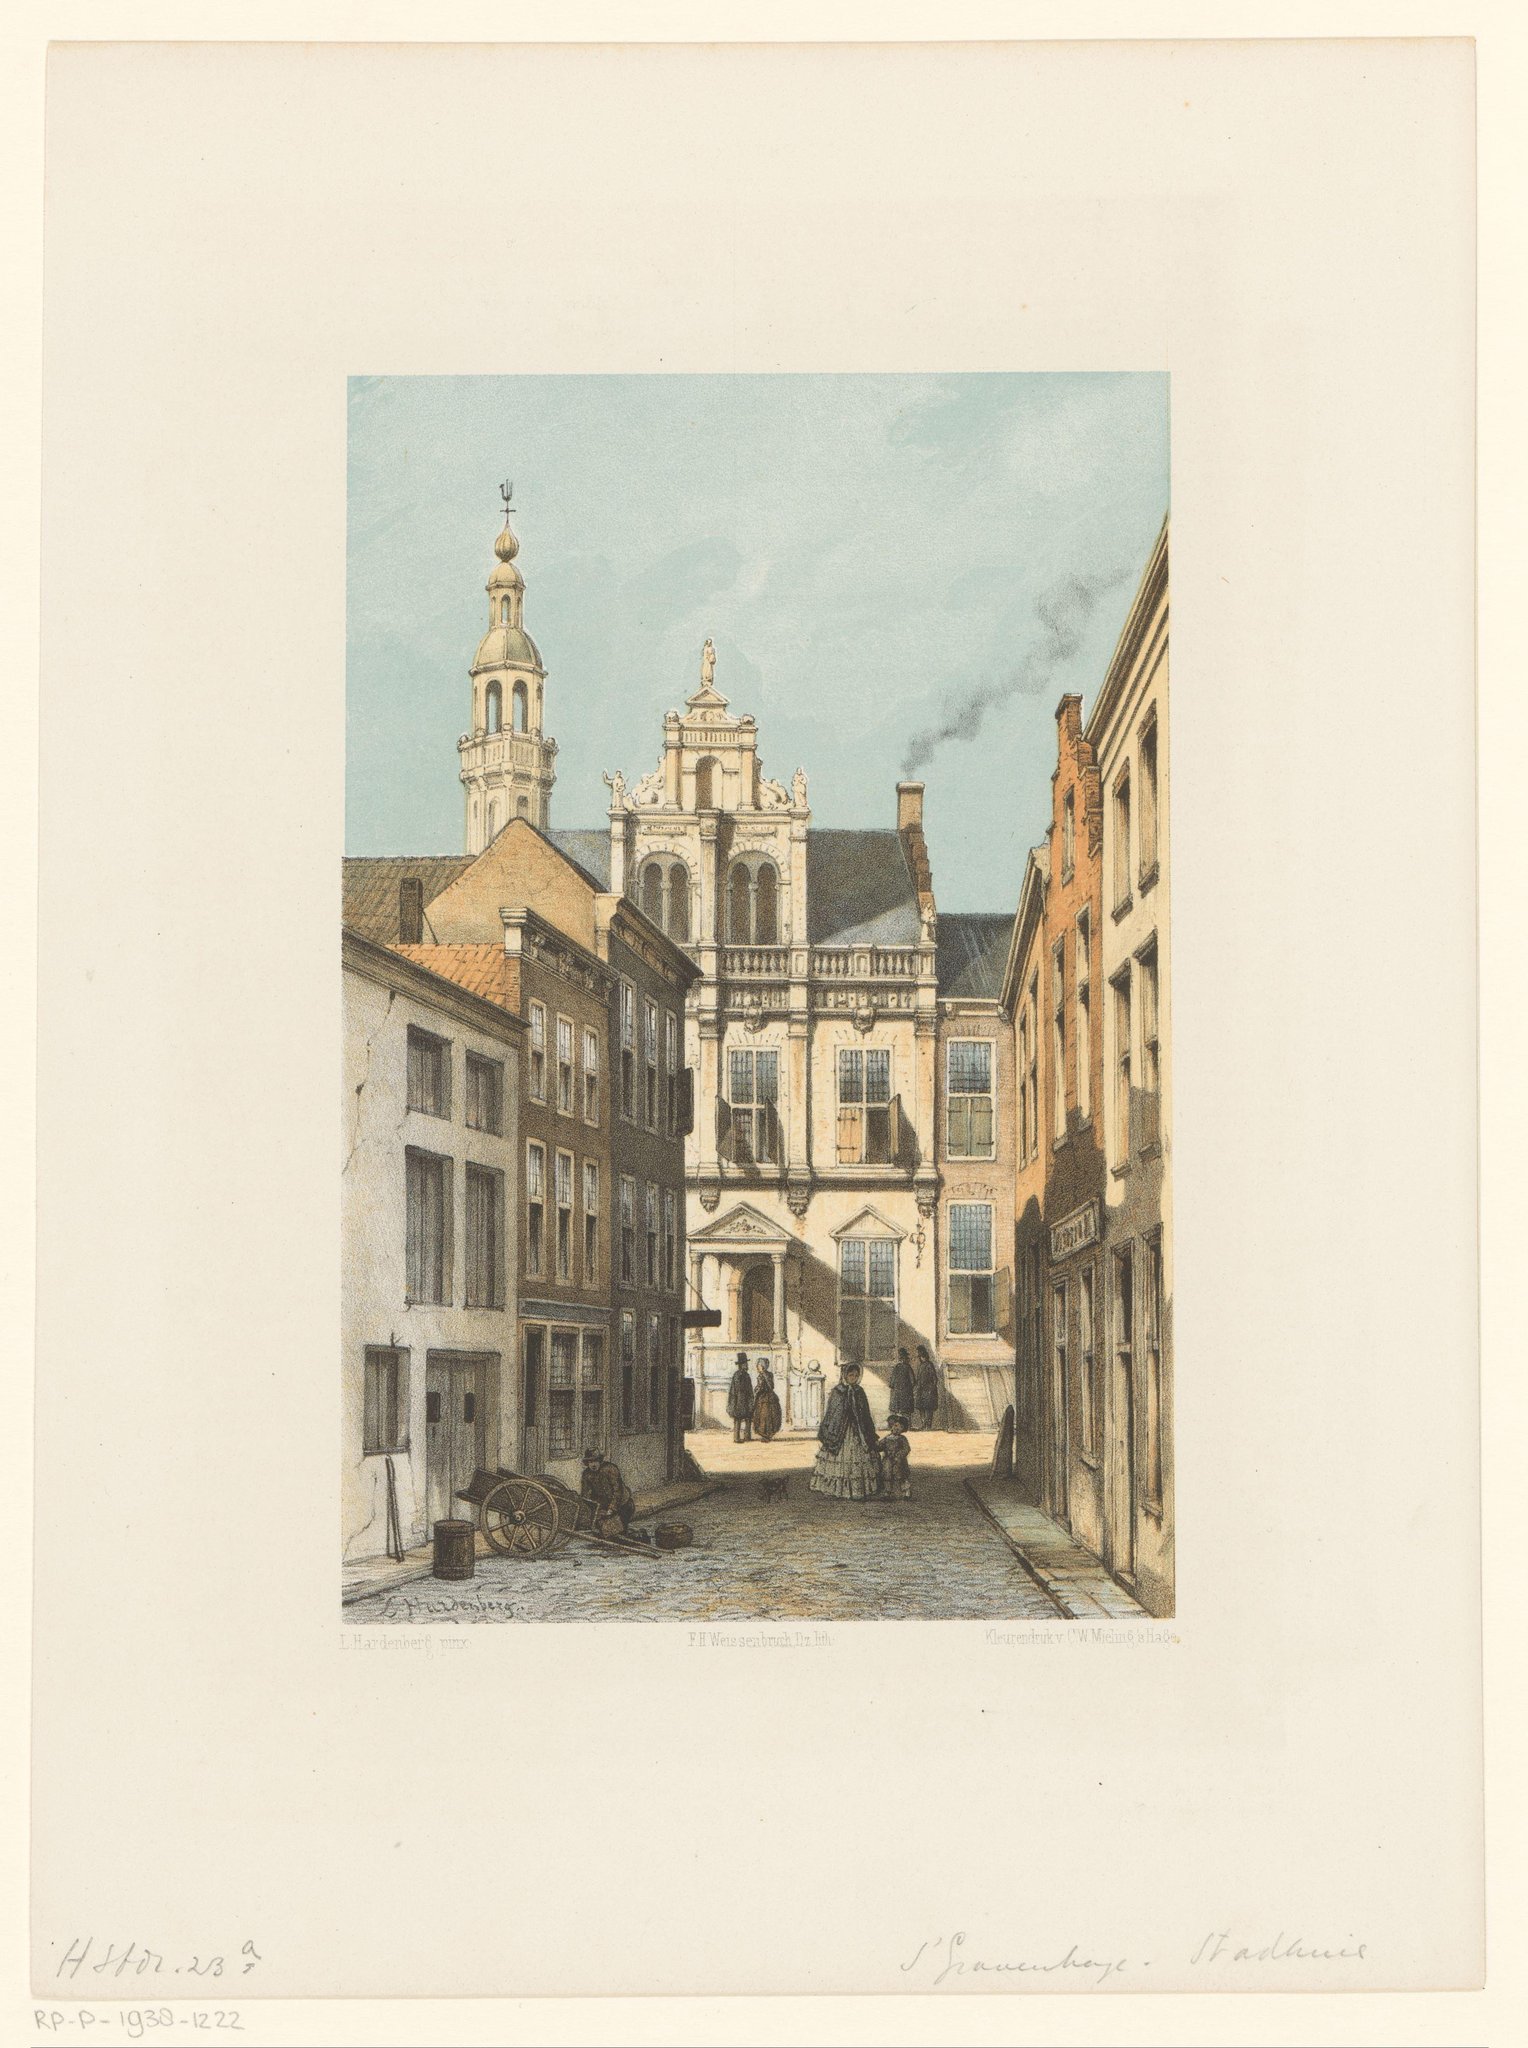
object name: print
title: Gezicht op het stadhuis van Den Haag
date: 1847-1865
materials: paper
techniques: lithograph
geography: the hague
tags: townhall, street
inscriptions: collector's mark: Lugt 2228, collector's mark: Lugt 2760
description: Gezicht op het stadhuis te Den Haag door een straat gezien. Op straat lopen figuren en zit links een figuur bij een kar.